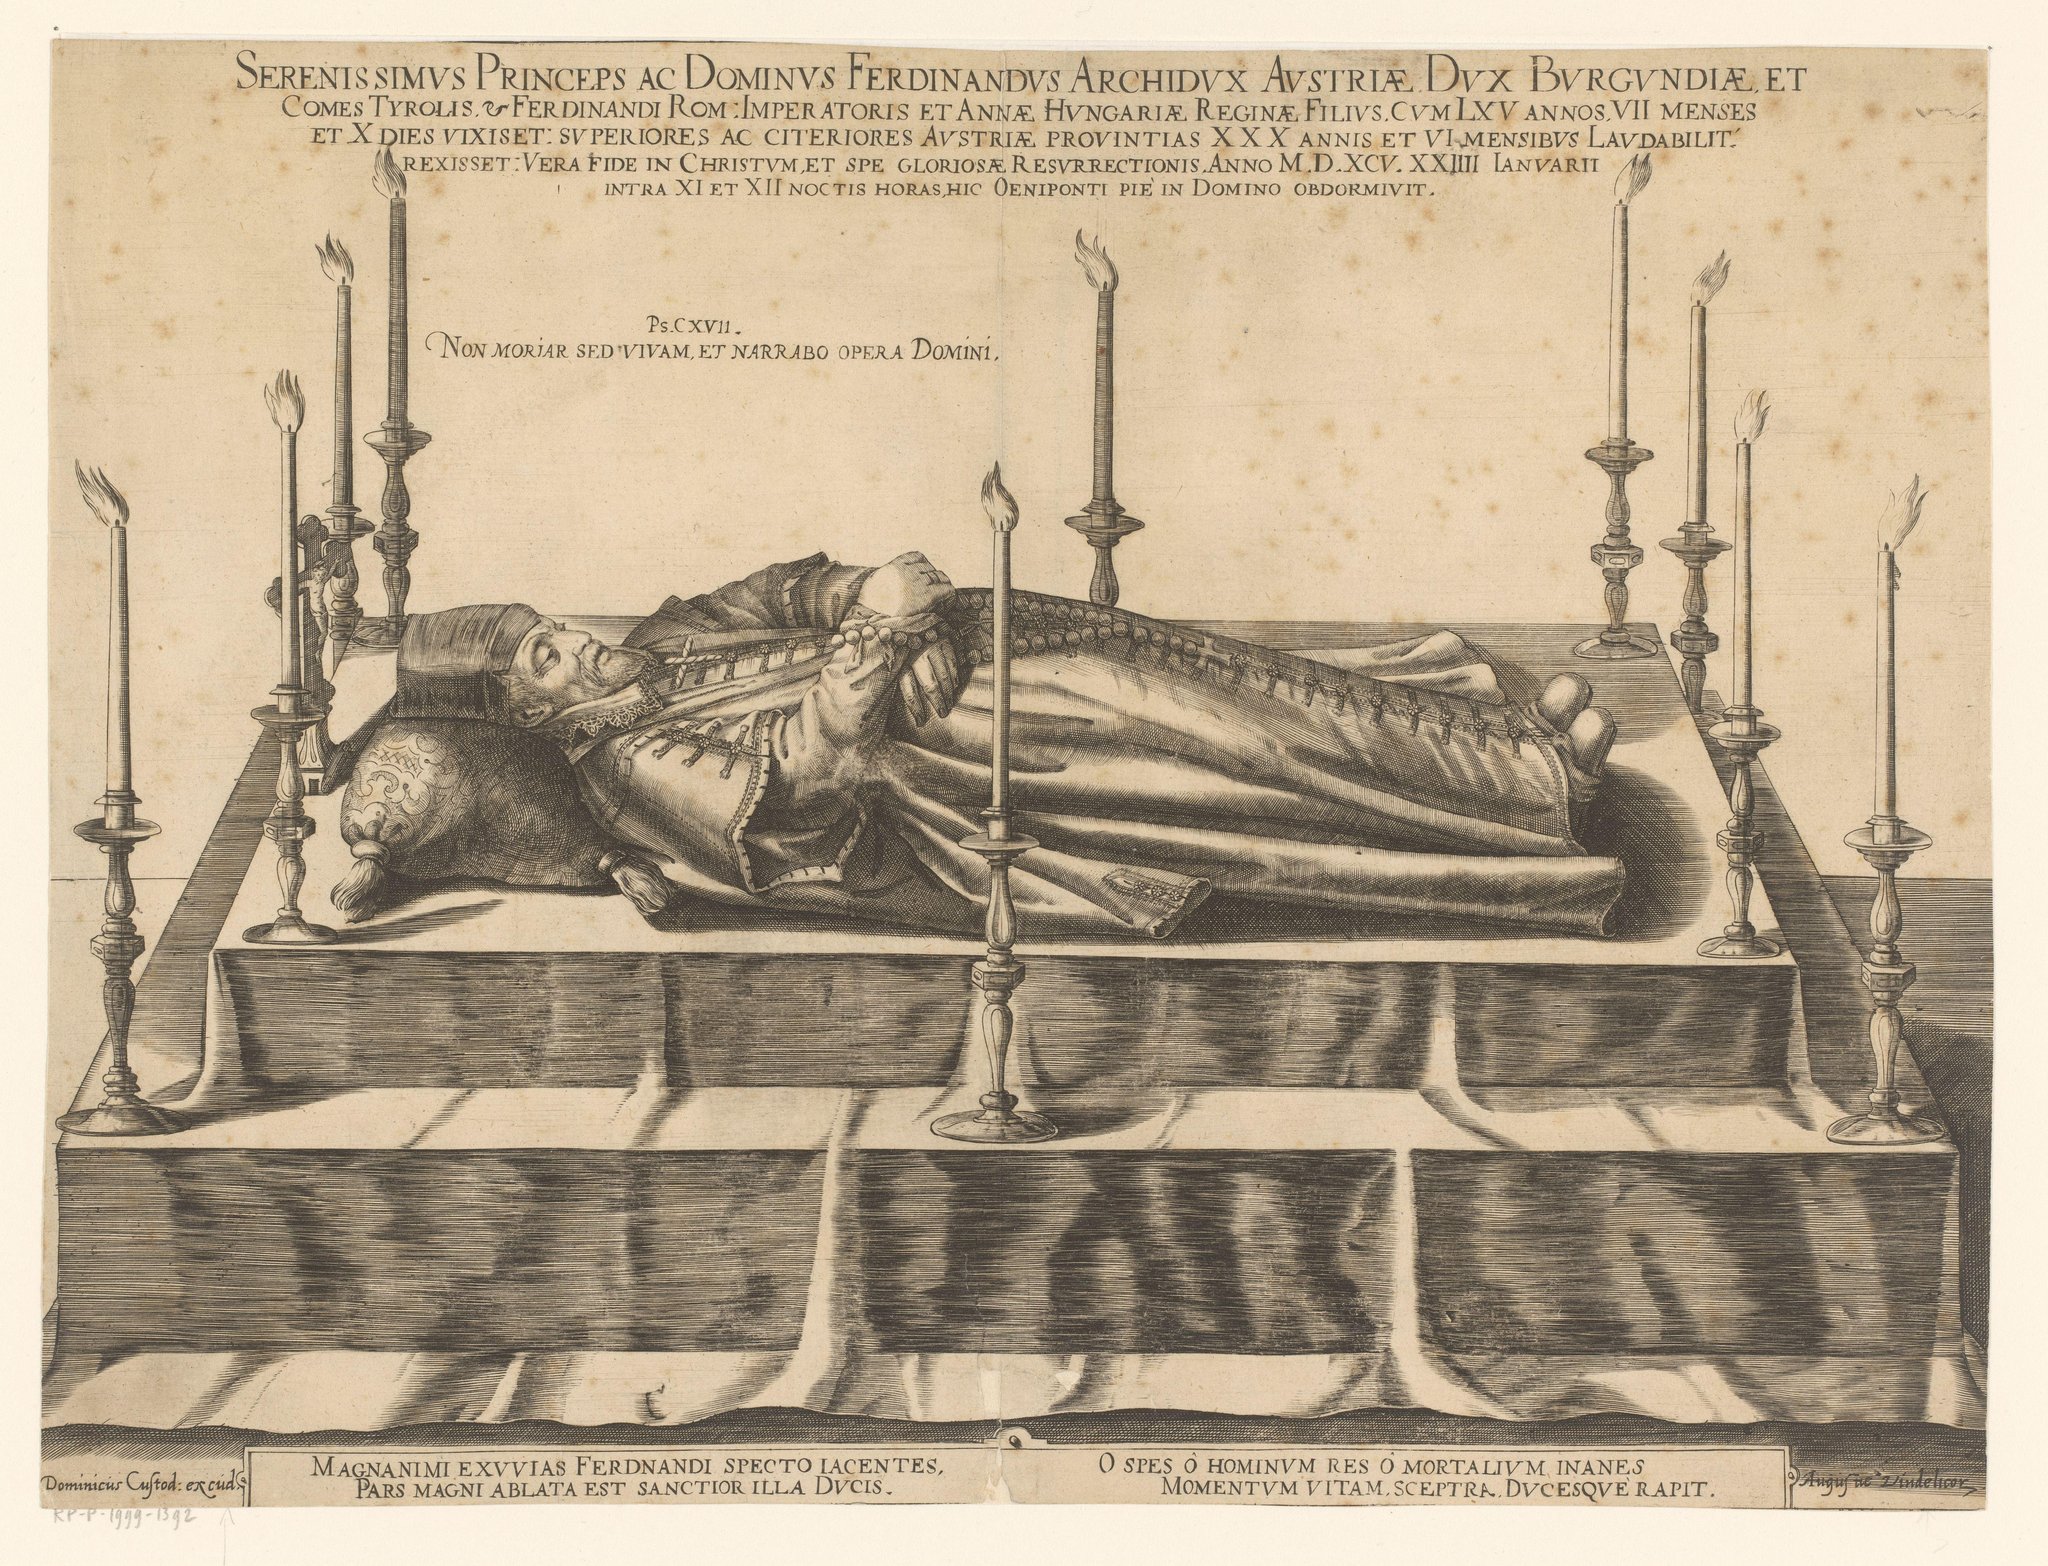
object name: print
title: Doodsportret van Ferdinand II van Tirol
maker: dominicus custos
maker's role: print maker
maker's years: 1560-1615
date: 1595-1615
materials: paper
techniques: engraving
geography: augsburg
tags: ferdinand ii van tirol, deathbed, historical persons, grave, tomb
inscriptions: collector's mark: Lugt 2228, collector's mark: Lugt 2760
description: Rechts staat 'Augustue Vindelicor'. Dit is de Latijnse naam voor Augsburg.